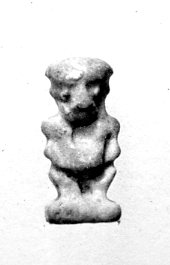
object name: amulet, pataikos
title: Pataikos amulet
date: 664-332 BCE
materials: faience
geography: egypt